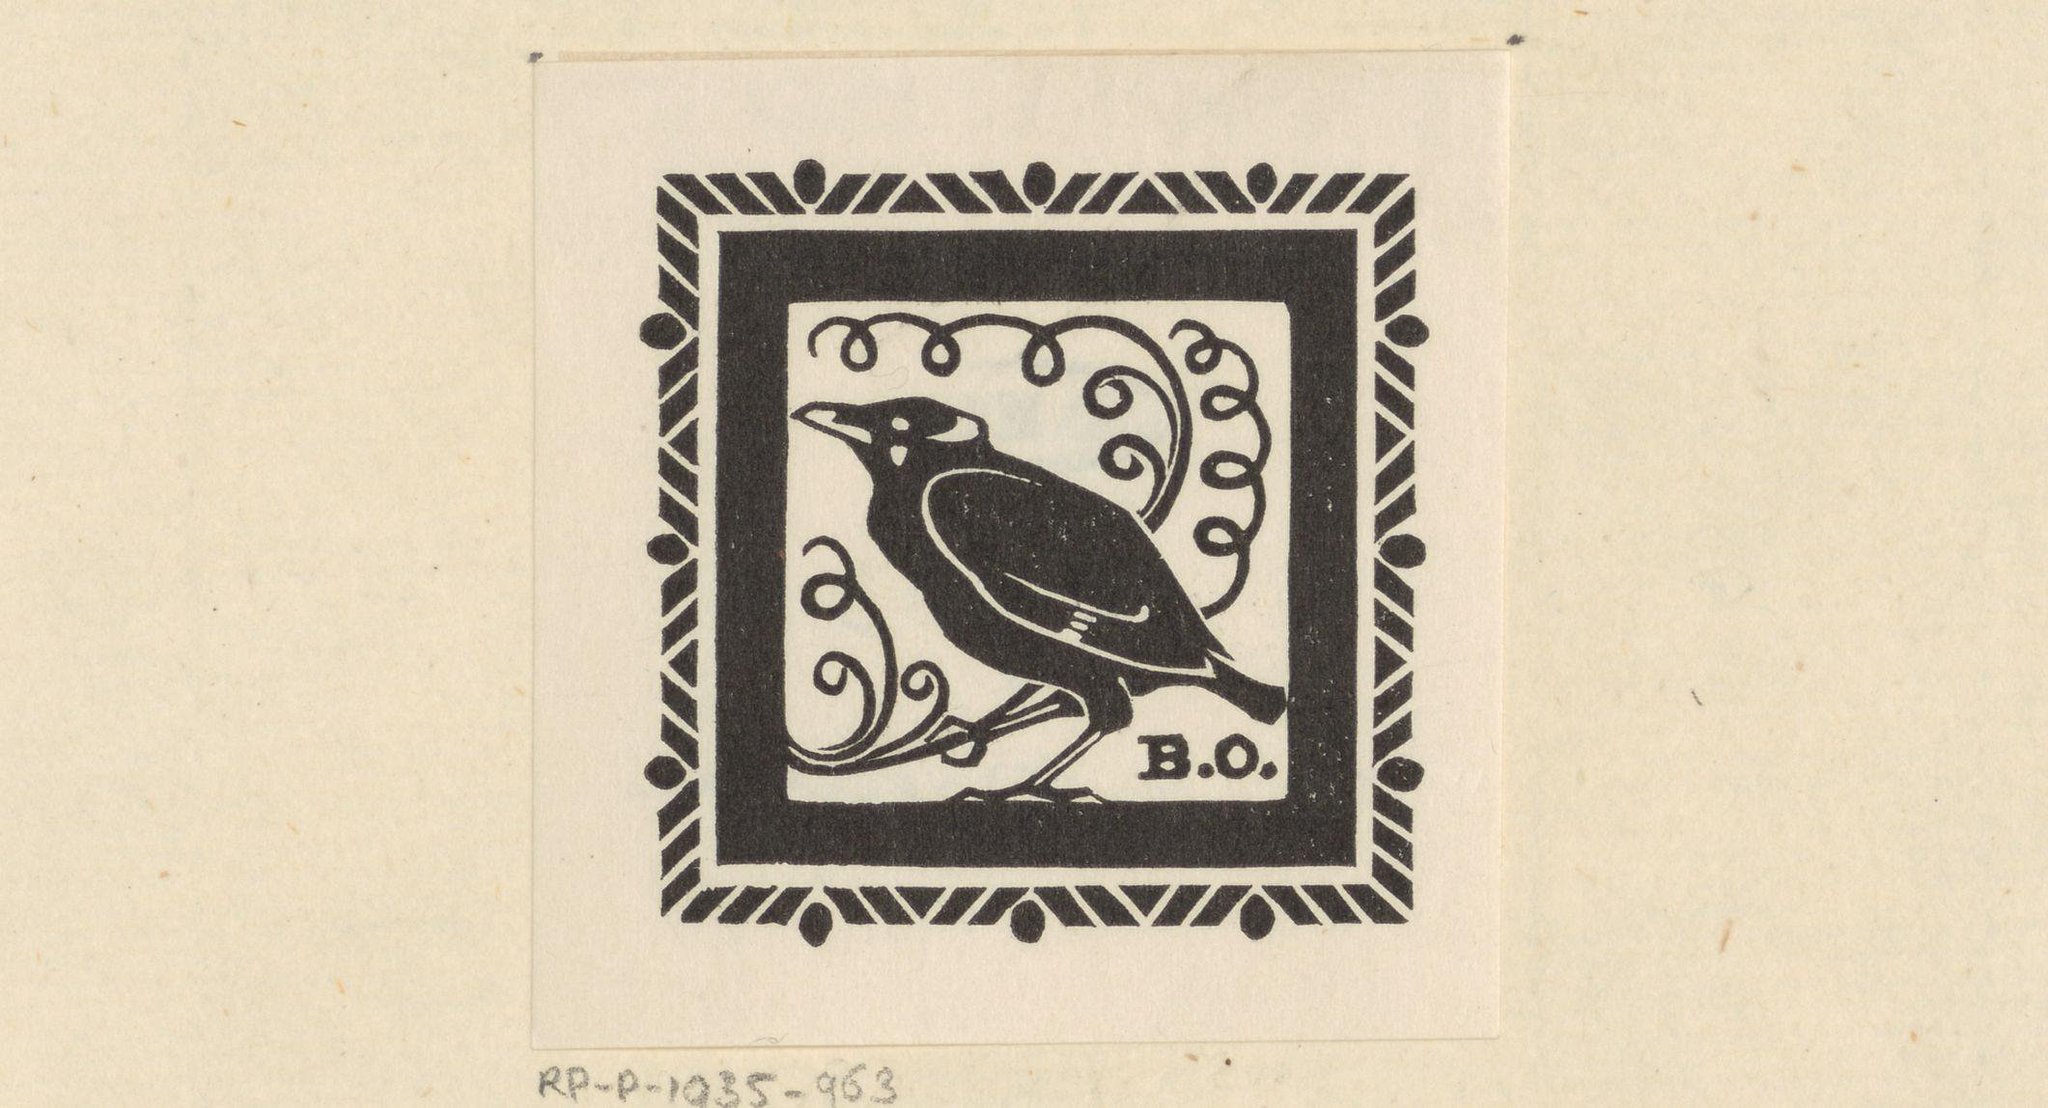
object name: bookplate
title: Ex libris van B.O.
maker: julie de graag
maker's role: draughtsman, print maker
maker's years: 1877-1924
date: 1887-1924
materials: paper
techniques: woodcut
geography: netherlands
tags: song-birds: raven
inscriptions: collector's mark: Lugt 2228